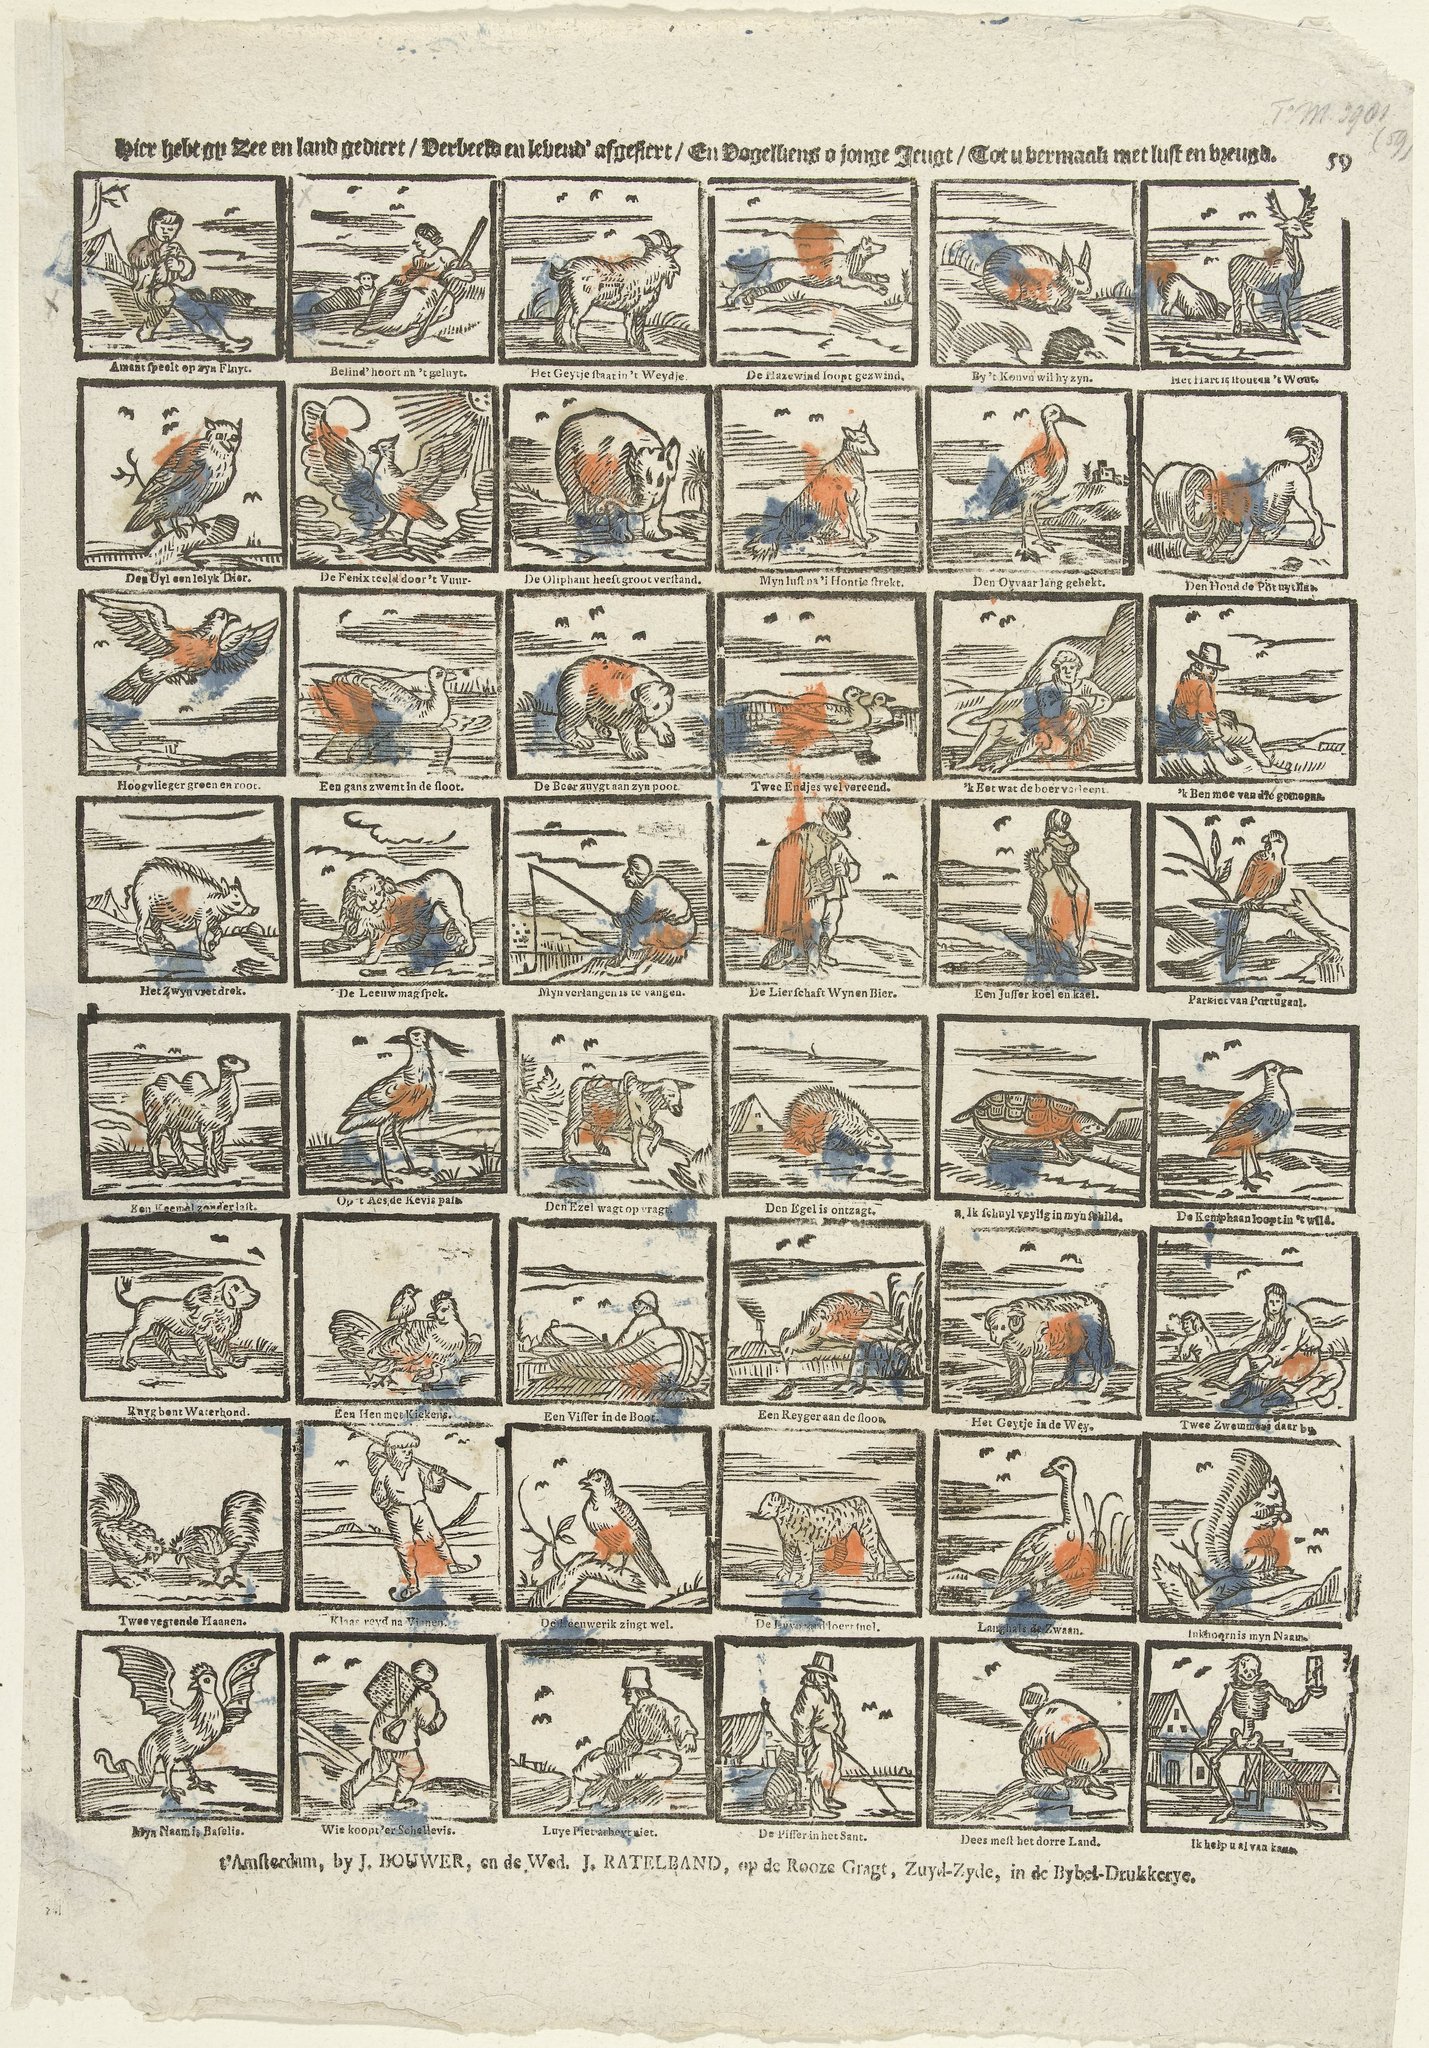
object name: print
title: Hier hebt gy zee en land gediert / Verbeeld en levend' afgesiert / En vogelkens o jonge jeugt / Tot u vermaak met lust en vreugd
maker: Anonymous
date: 1794-1804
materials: paper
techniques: colour, letterpress printing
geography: netherlands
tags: animals, human types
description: Blad met 48 voorstellingen van dieren en mensen. Onder elke afbeelding een onderschrift. Genummerd rechtsboven: 59.